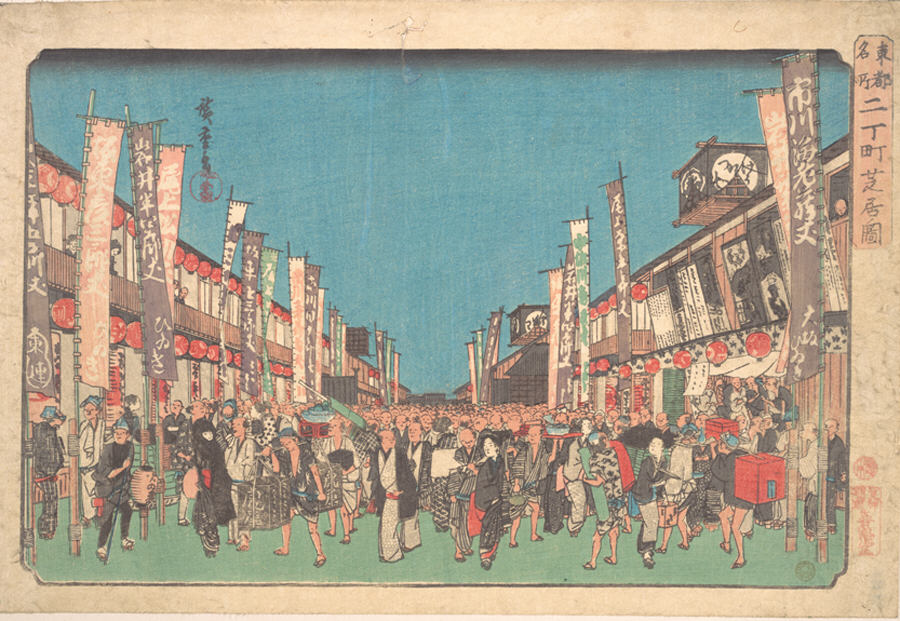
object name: print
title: Sakai Cho Shibai no Zu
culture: japanese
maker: utagawa hiroshige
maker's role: artist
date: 1838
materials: ink, paper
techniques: woodblock print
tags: crowd,street scene